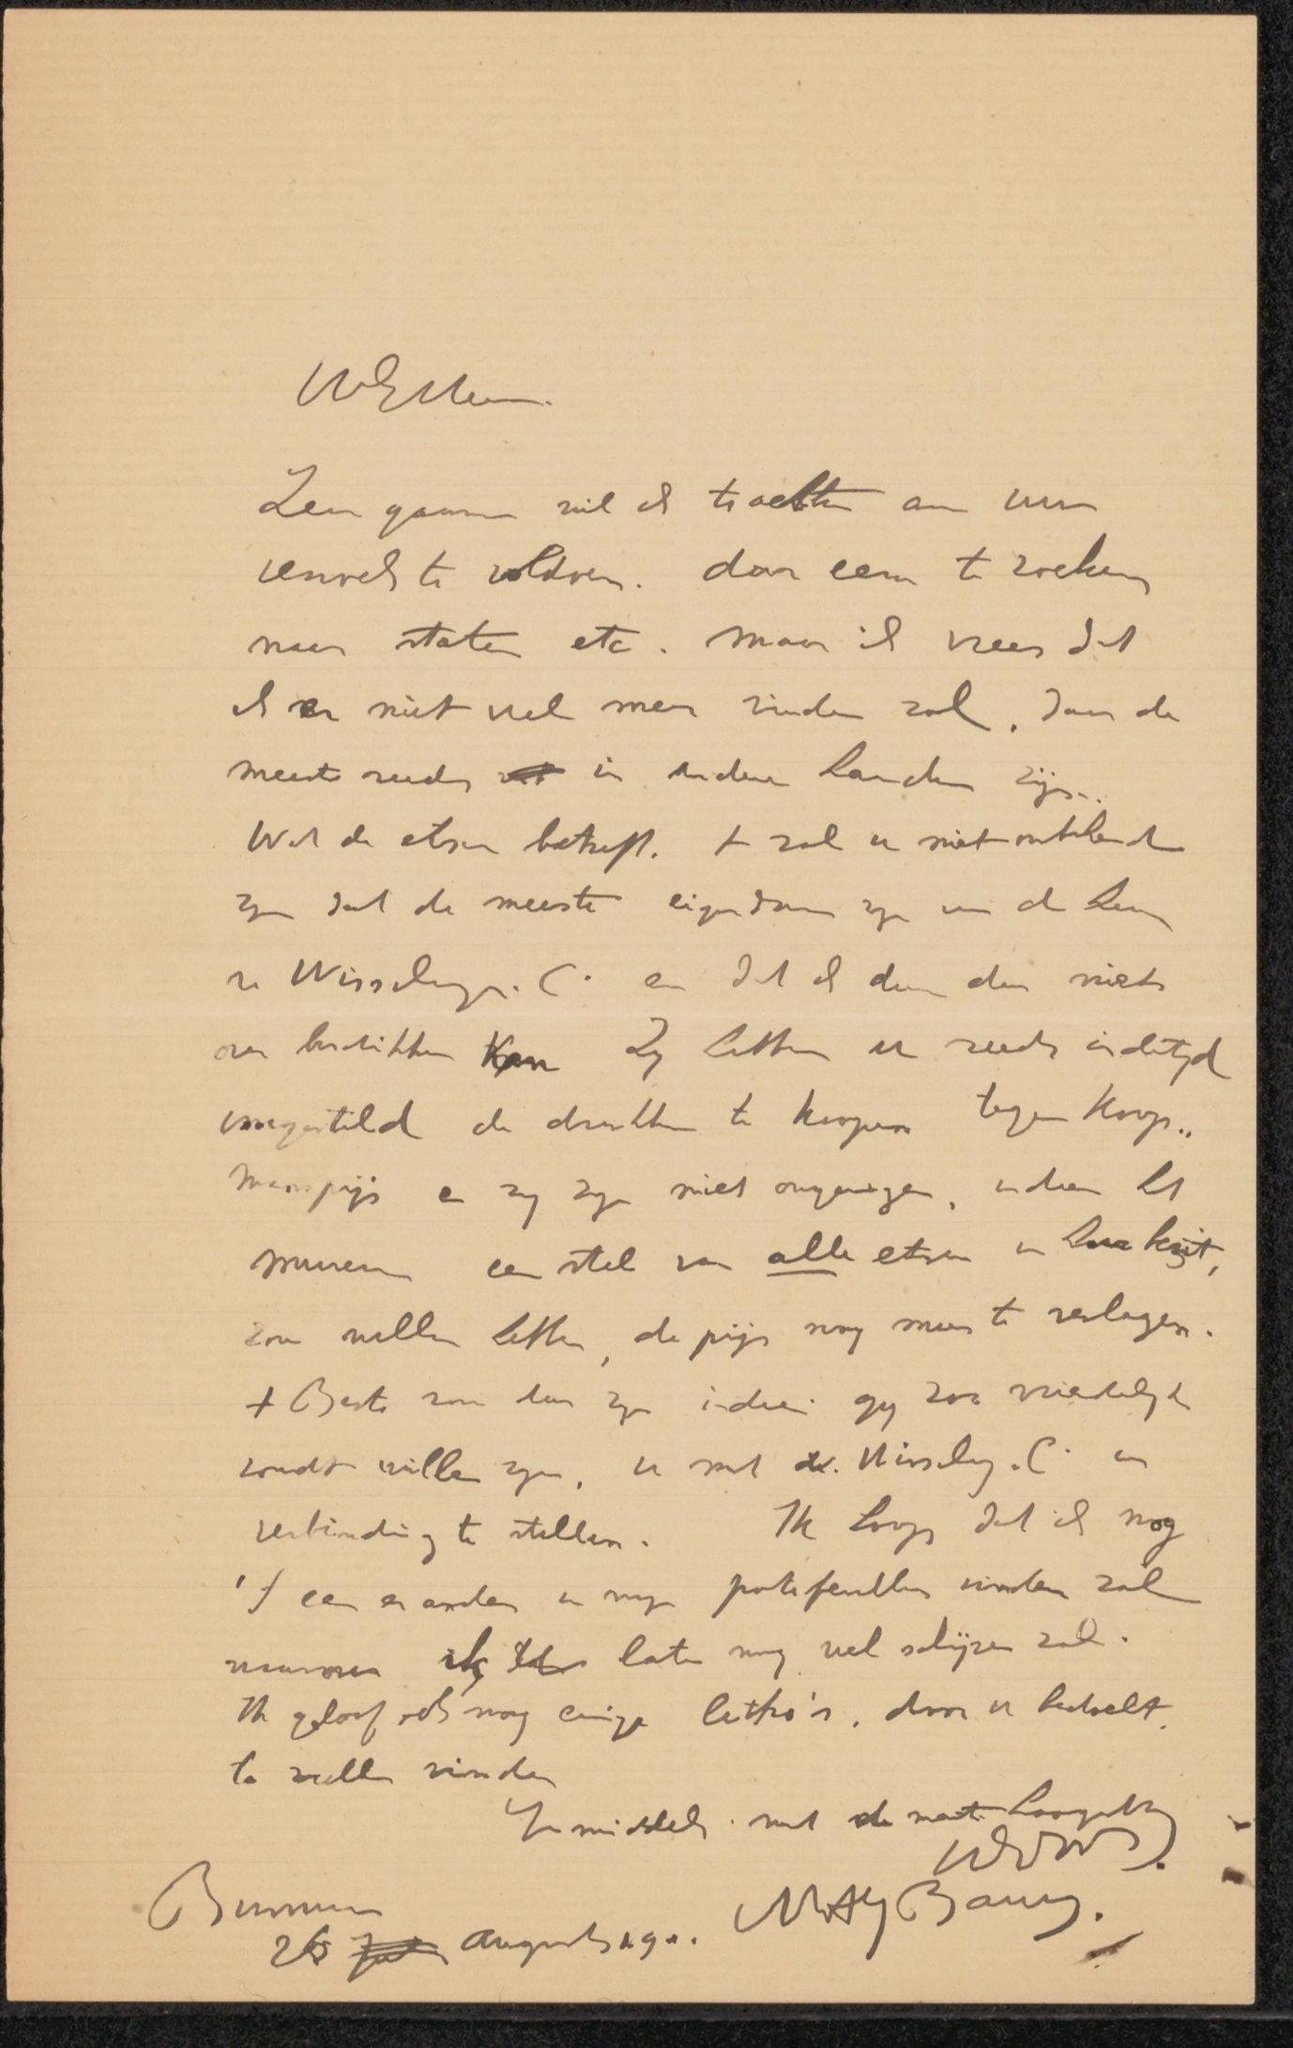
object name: letter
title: Brief aan Pieter Haverkorn van Rijsewijk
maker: marius bauer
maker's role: draughtsman, print maker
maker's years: 1867-1932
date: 1911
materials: ink, paper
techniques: pen, writing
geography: bussum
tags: pieter haverkorn van rijsewijk, art trade, art shop, the graphic arts, art collecting